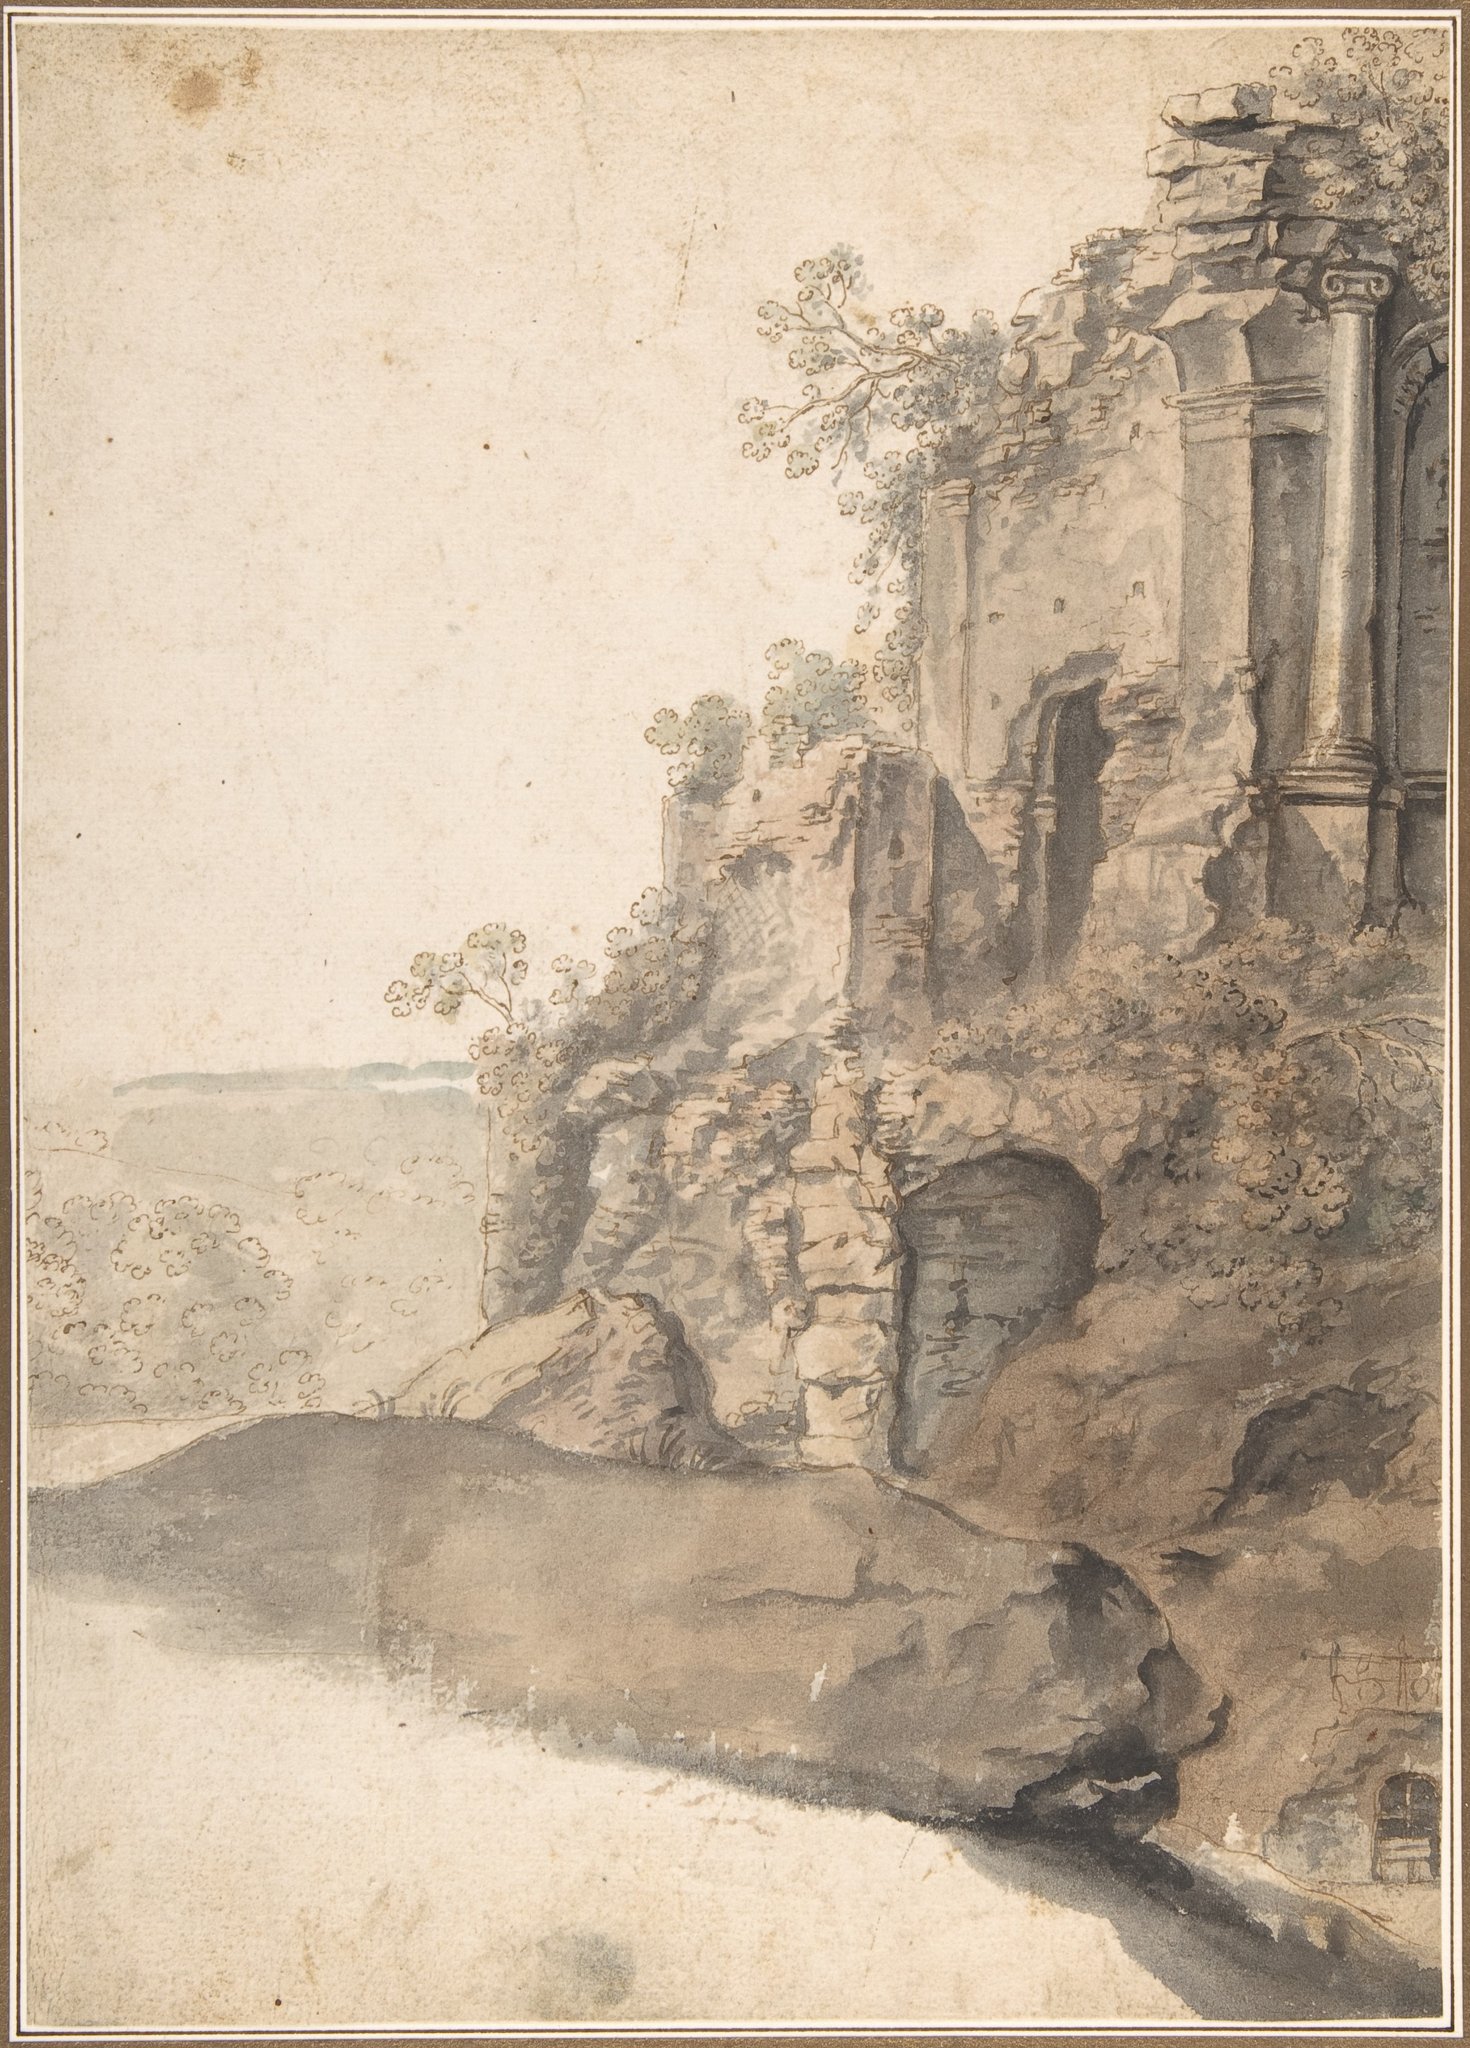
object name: drawing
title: Landscape with Roman Ruins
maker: cornelis van poelenburch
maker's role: artist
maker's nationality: dutch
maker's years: 1594-1667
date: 1609-1667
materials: chalk, ink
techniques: brush, pen, wash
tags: ruins,landscapes,plants